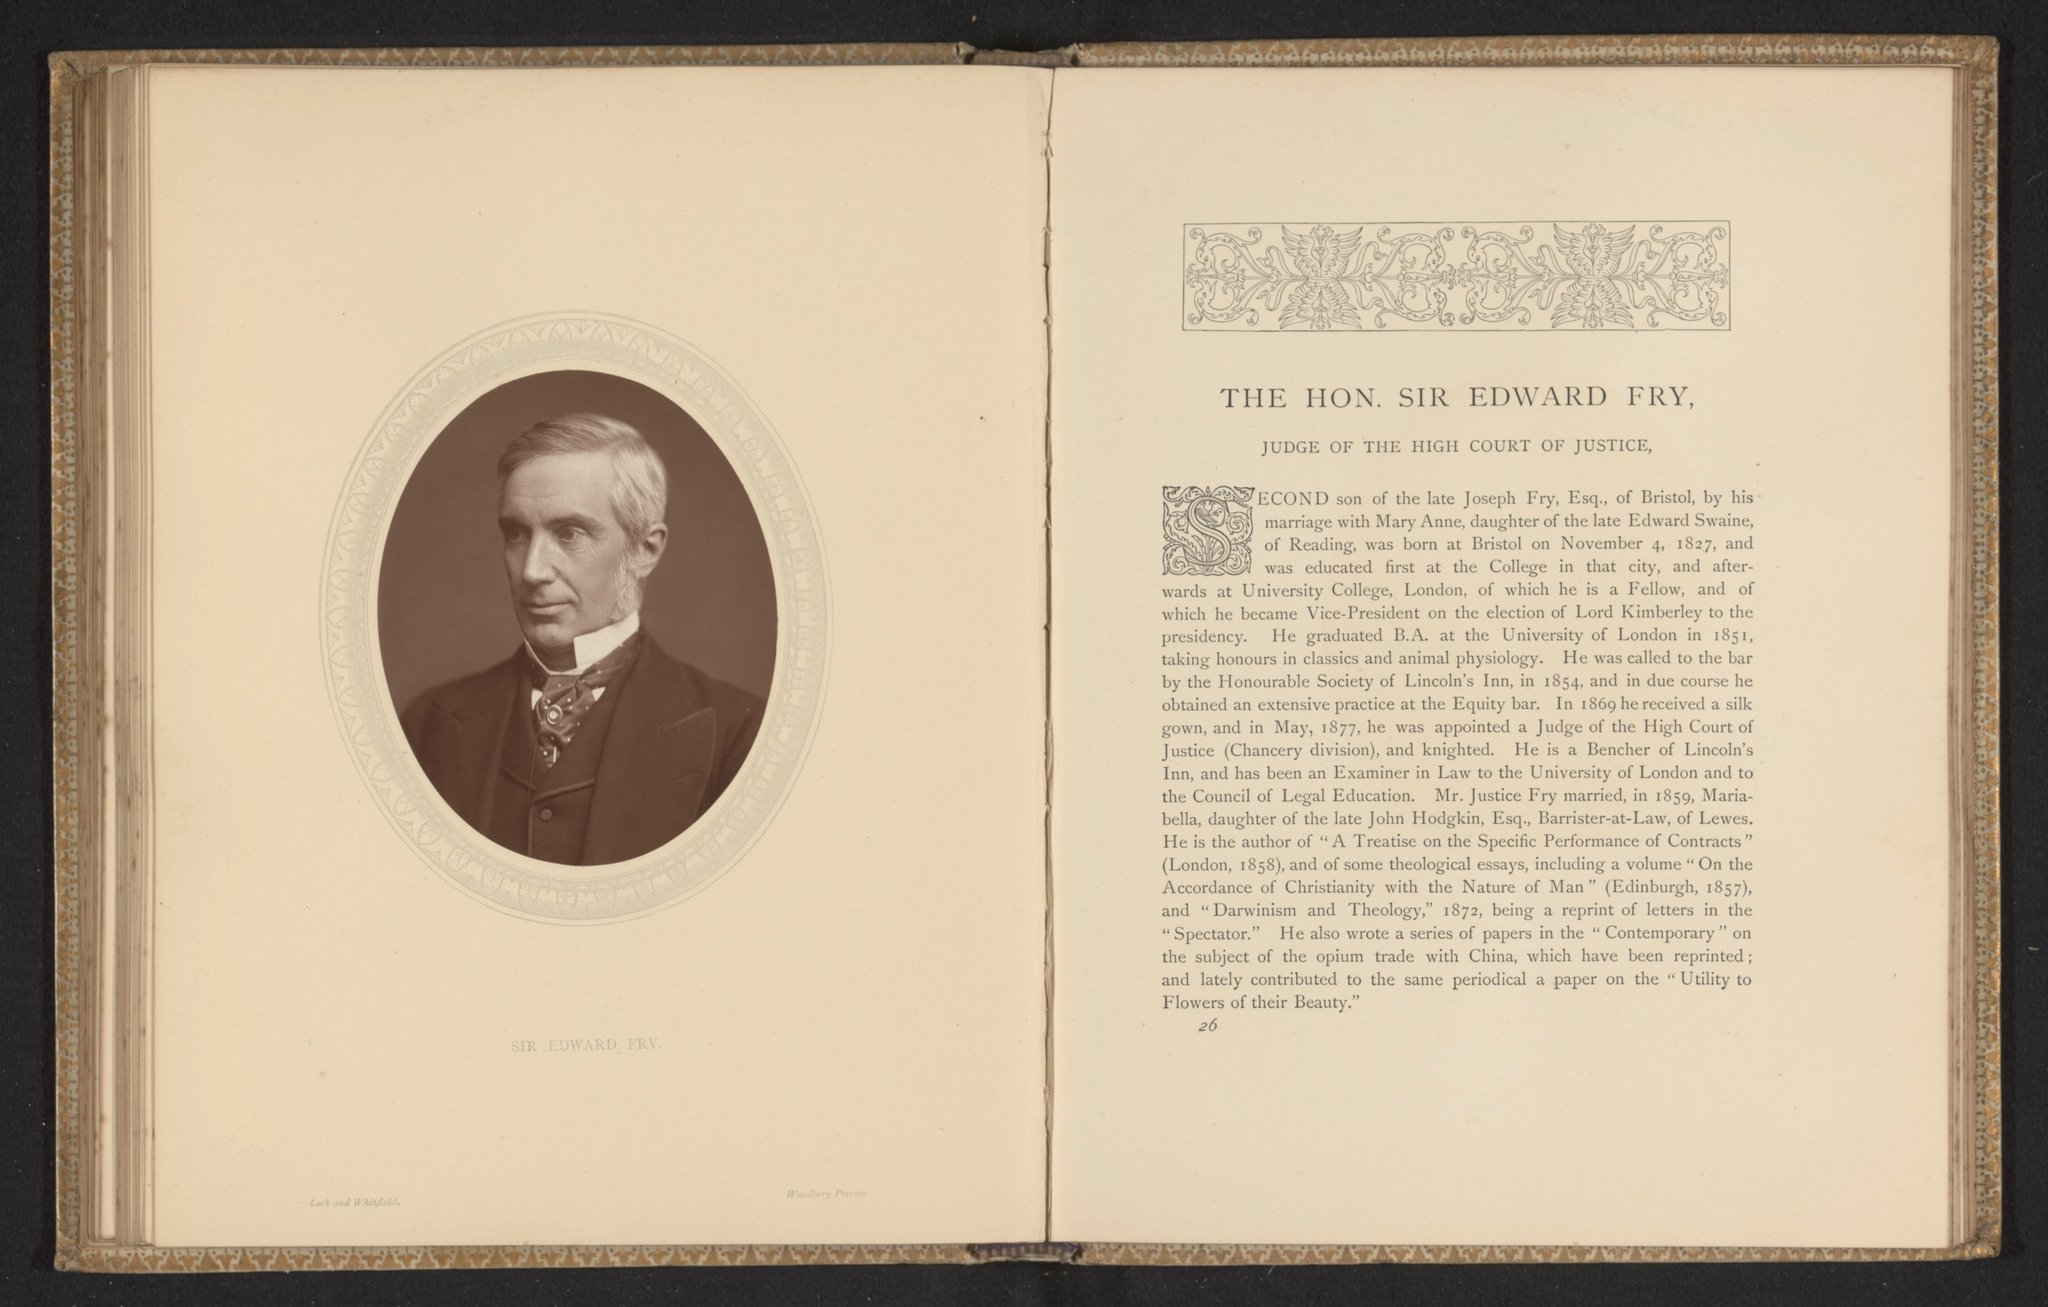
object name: page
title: Sir Edward Fry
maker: Anonymous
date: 1876-1881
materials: paper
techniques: woodburytype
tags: historical persons (portraits and scenes from the life) (+ (full) bust portrait), magistracy, judges